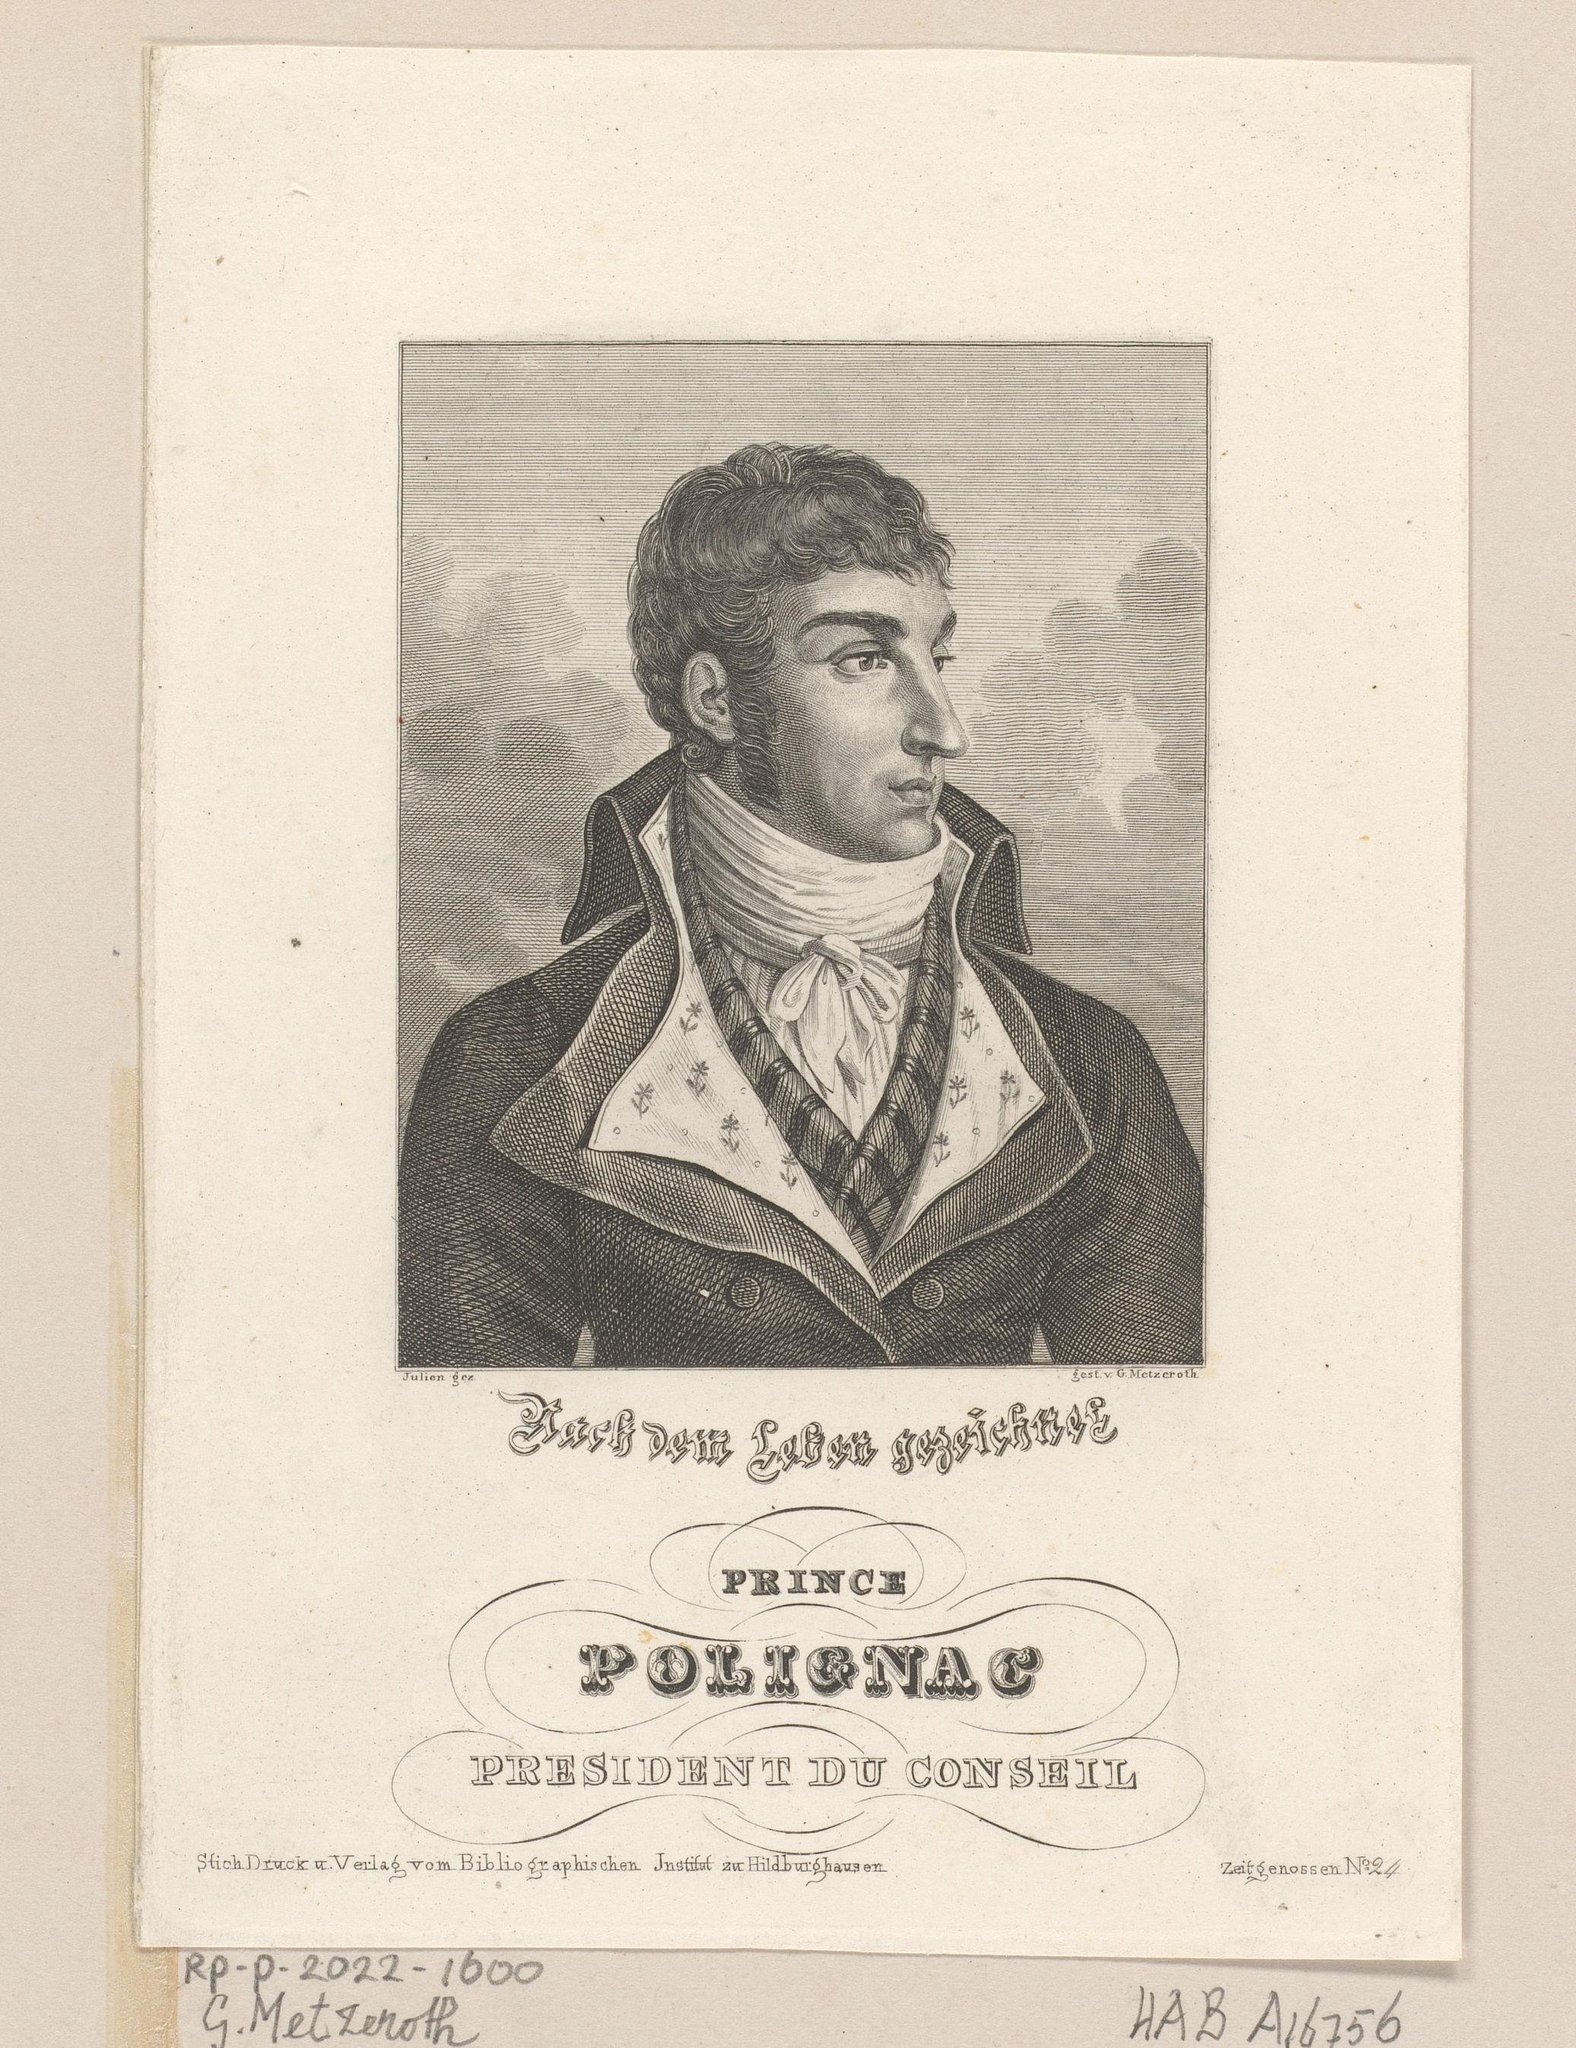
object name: print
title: Tijdgenoten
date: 1829-1840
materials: paper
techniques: engraving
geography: hildburghausen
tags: politician, historical persons, politician, e.g. party leader